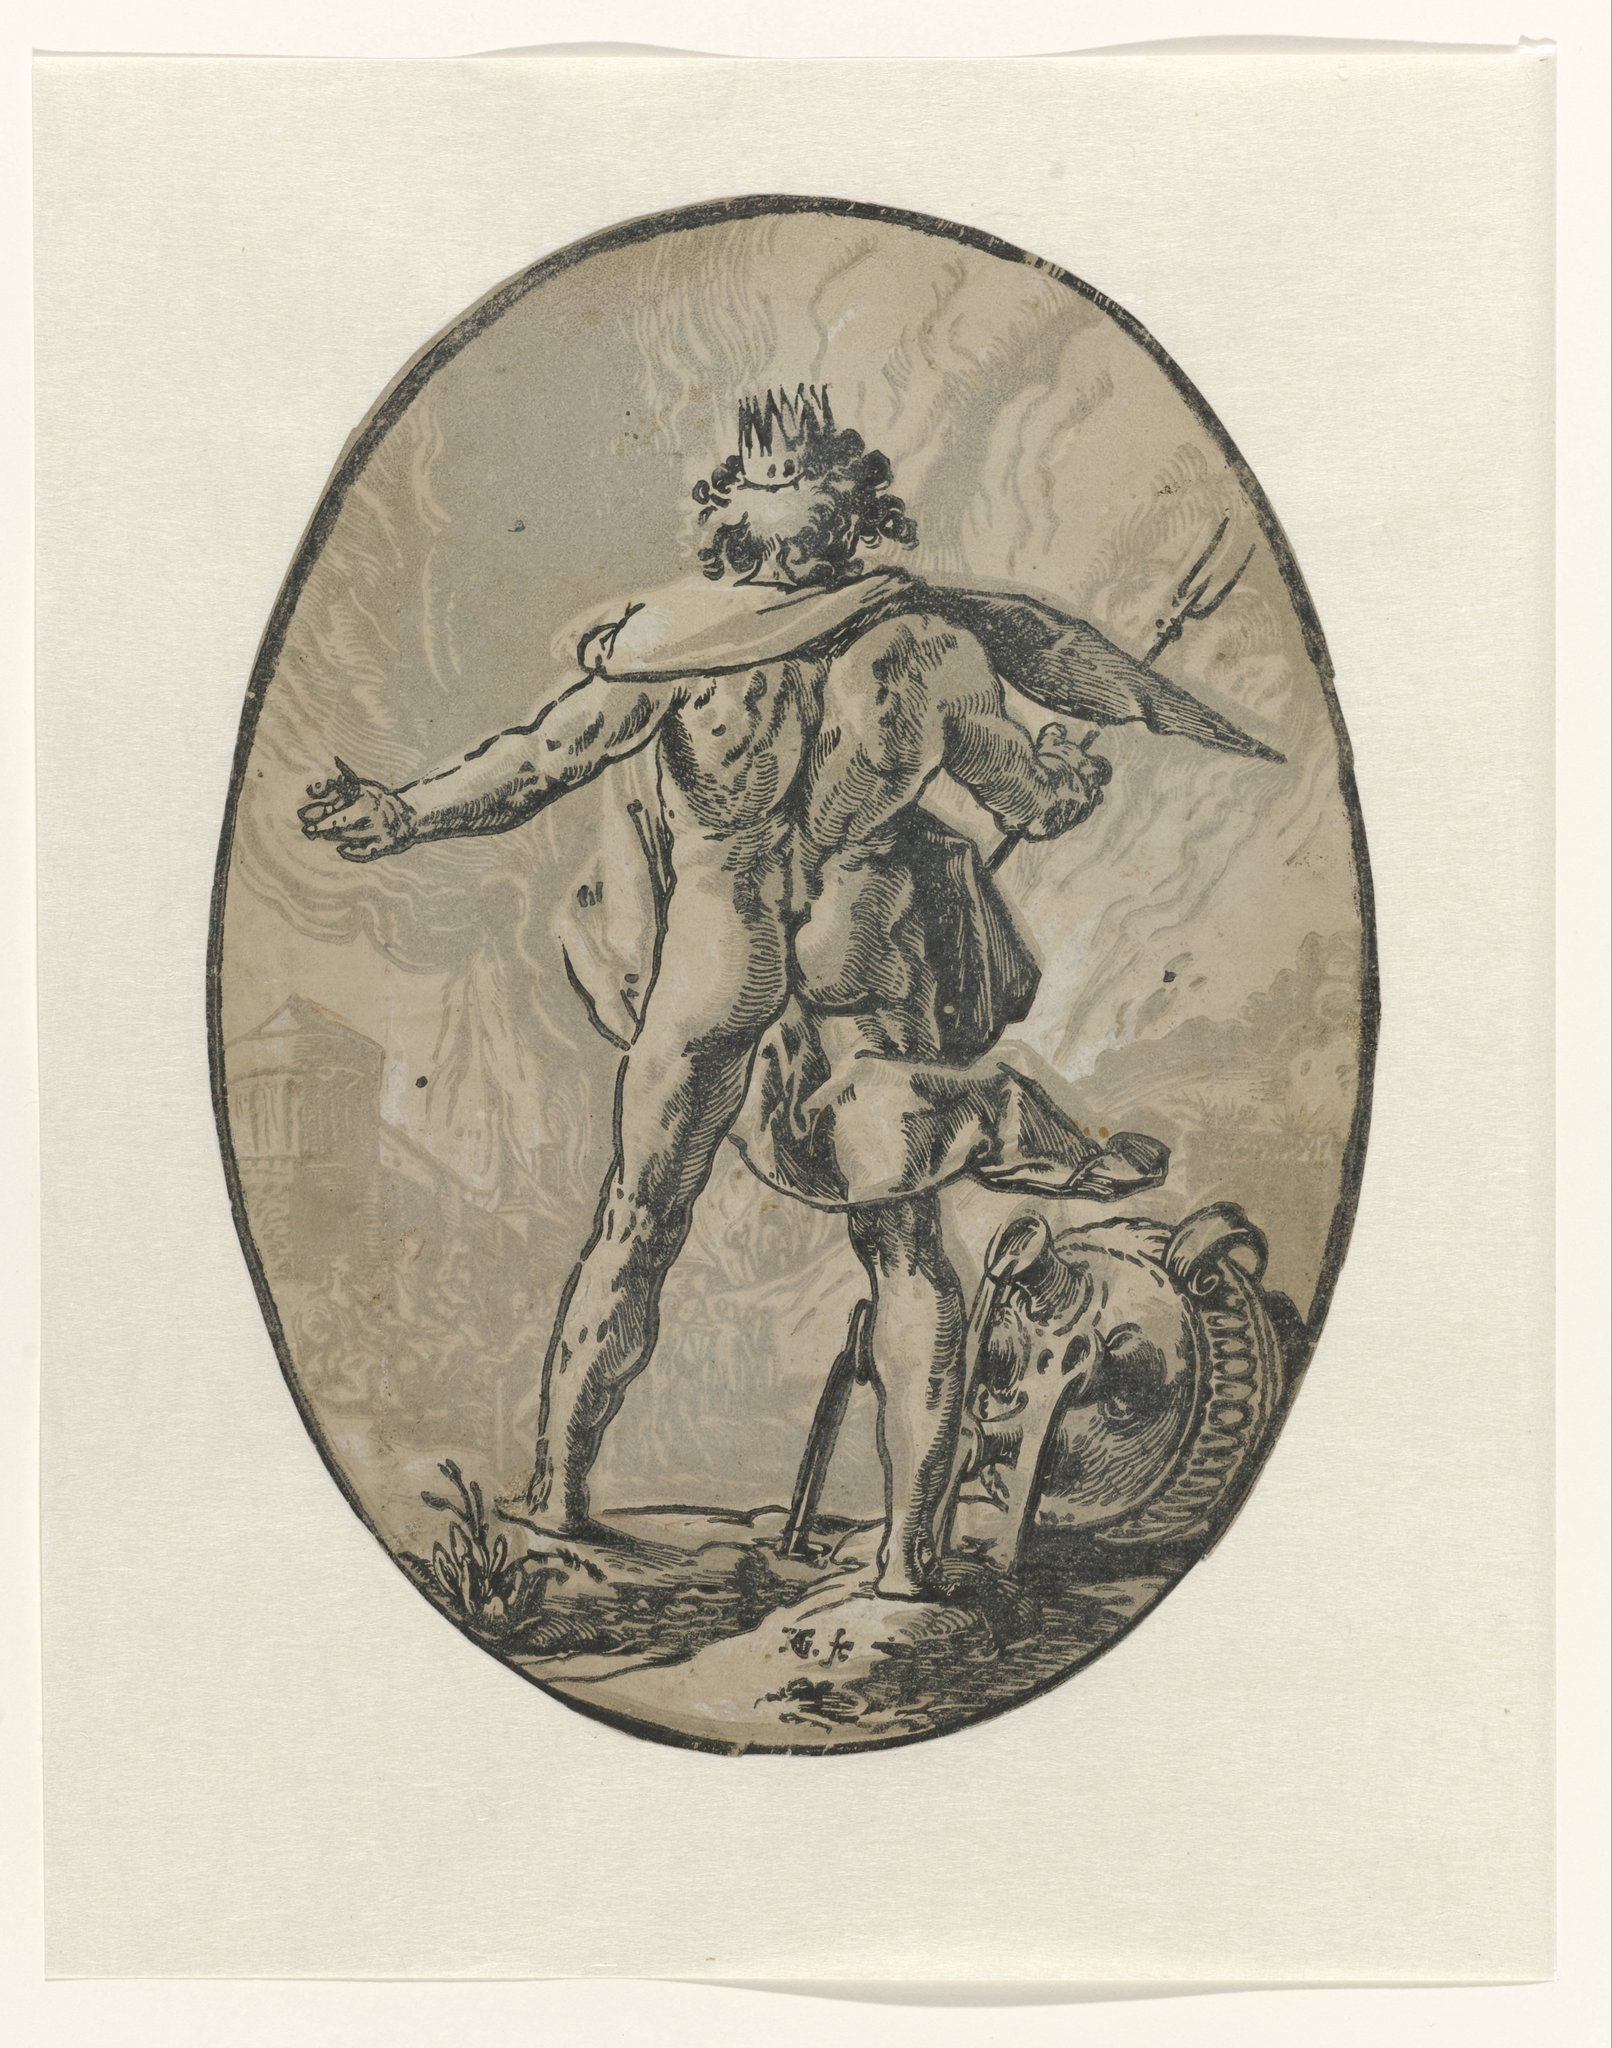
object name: print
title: Pluto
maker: hendrick goltzius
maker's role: draughtsman, painter, print maker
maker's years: 1558-1617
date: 1588-1590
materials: paper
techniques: woodcut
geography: netherlands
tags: (story of) pluto (hades), dis pater, orcus